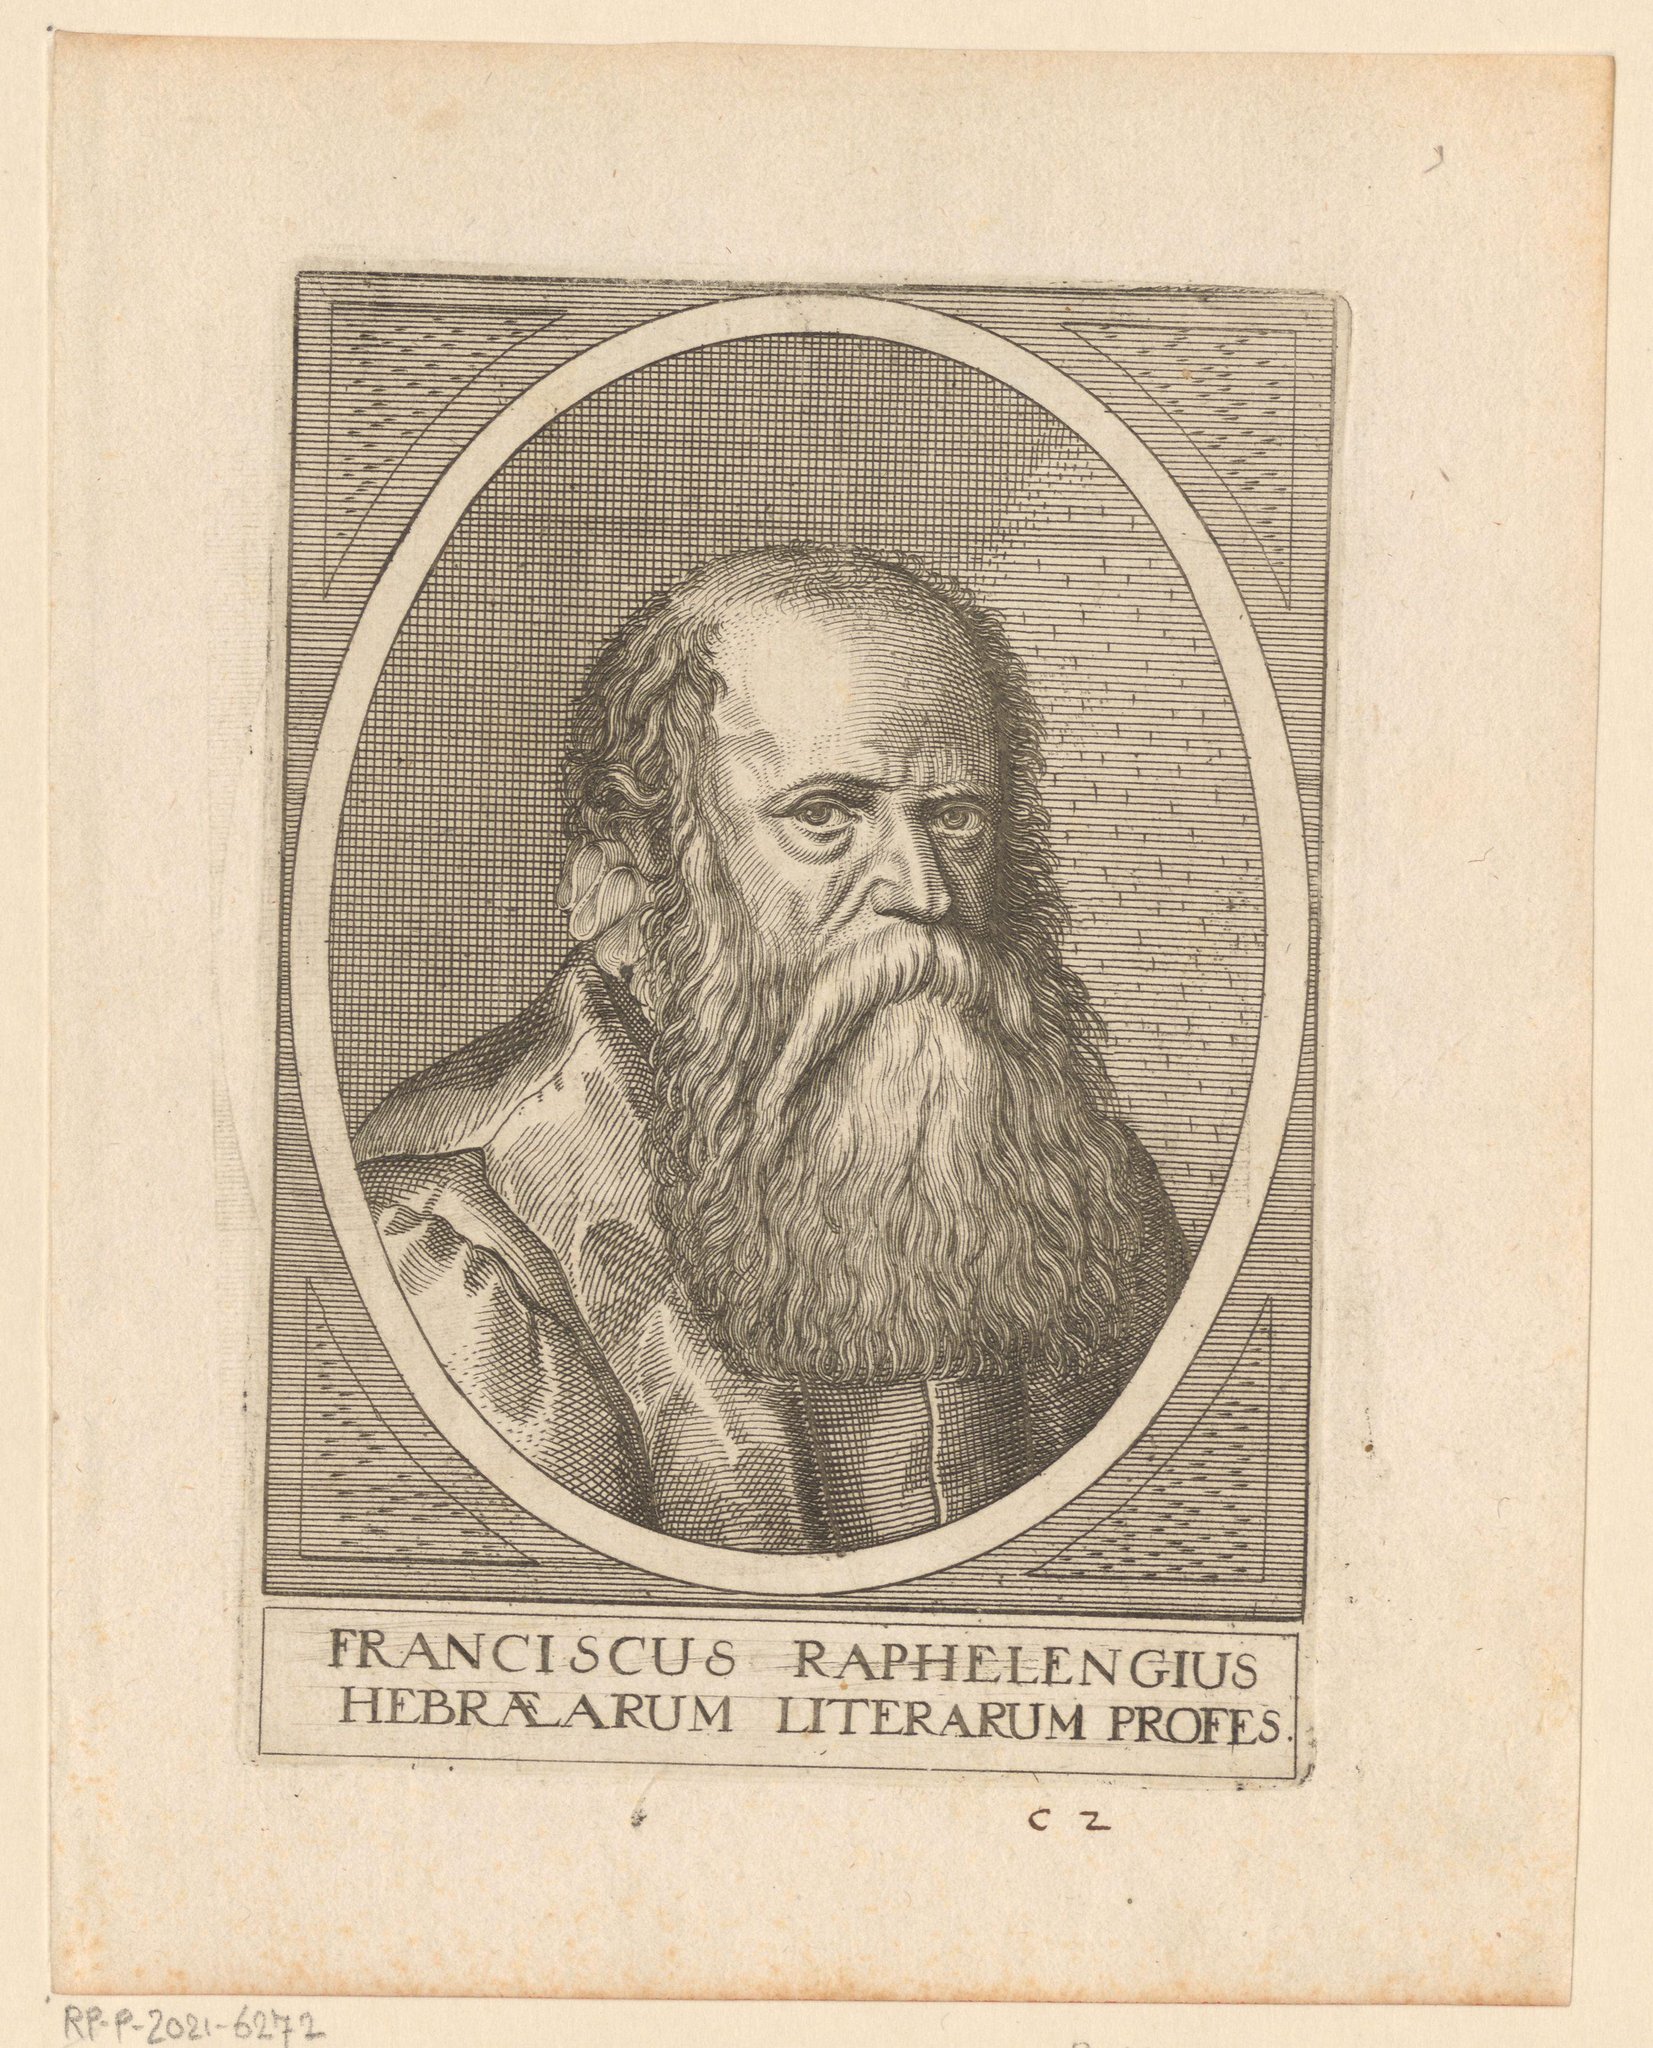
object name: print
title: Bibliotheca chalcographica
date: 1650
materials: paper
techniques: engraving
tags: france, leiden, franciscus raphelengius (i), historical persons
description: Latere staat van de prent uit: Boissard, Jean Jacques. Bibliotheca chalcographica (...). Frankfurt am Main: Johannes Ammon, 1650, dl. 7.